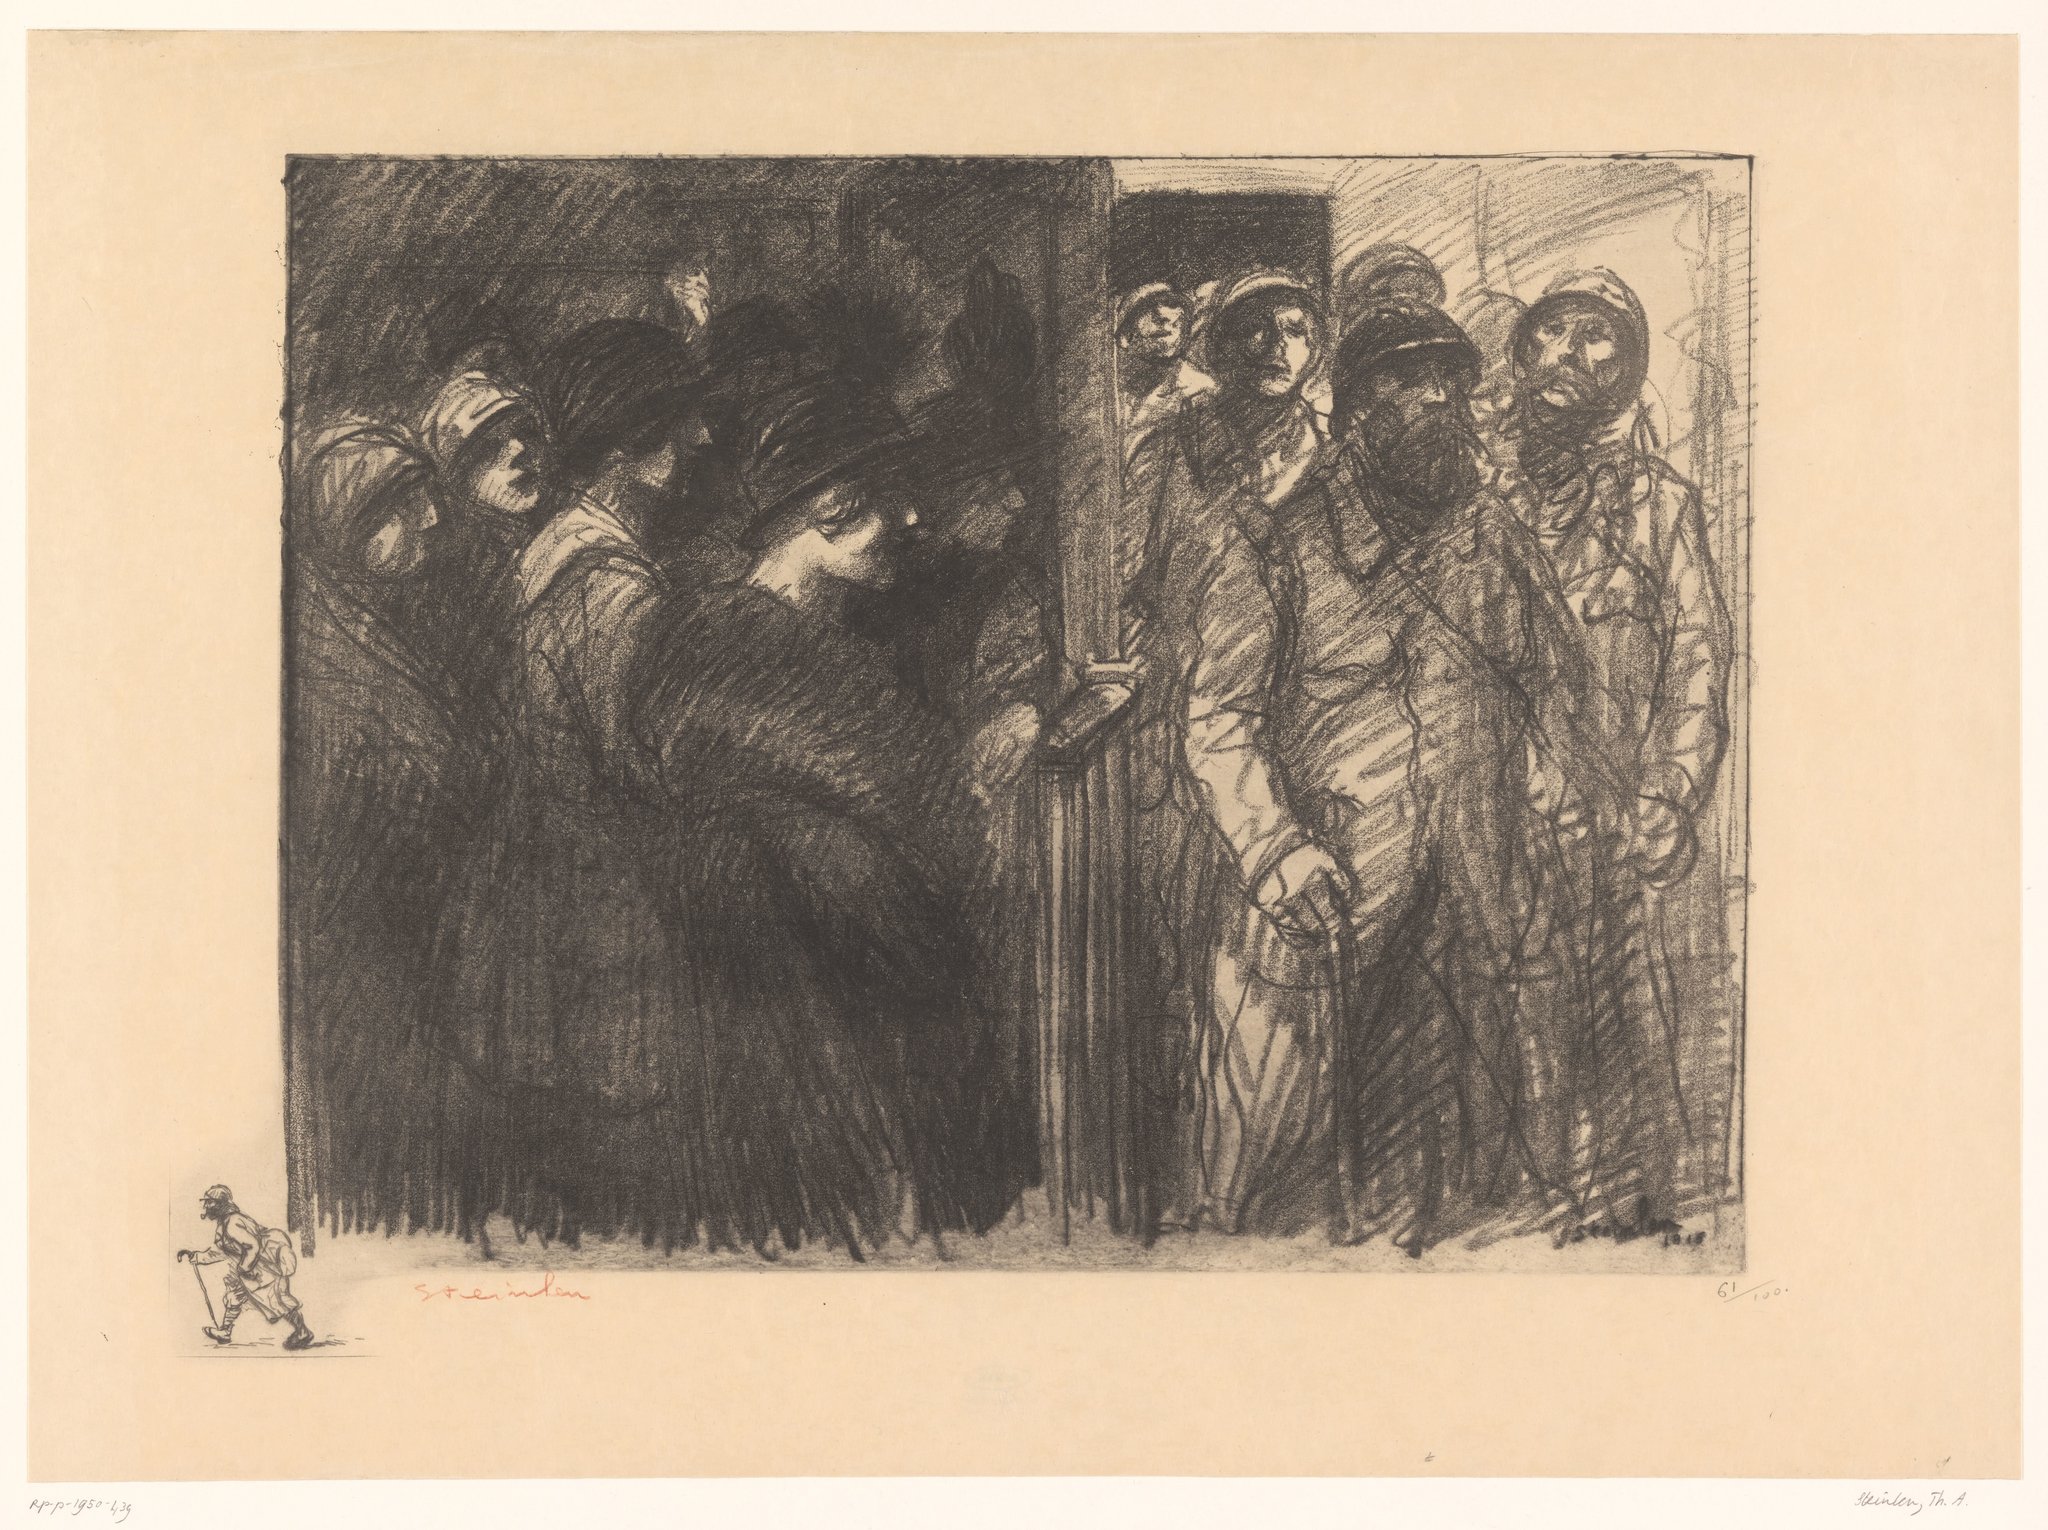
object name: print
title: Vrouwen wachten op terugkerende mannen tijdens de Eerste Wereldoorlog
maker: théophile alexandre steinlen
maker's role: draughtsman, painter, print maker, sculptor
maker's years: 1859-1923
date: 1916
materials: paper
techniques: lithograph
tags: the soldier; the soldier's life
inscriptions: signature: ‘Steinlen’